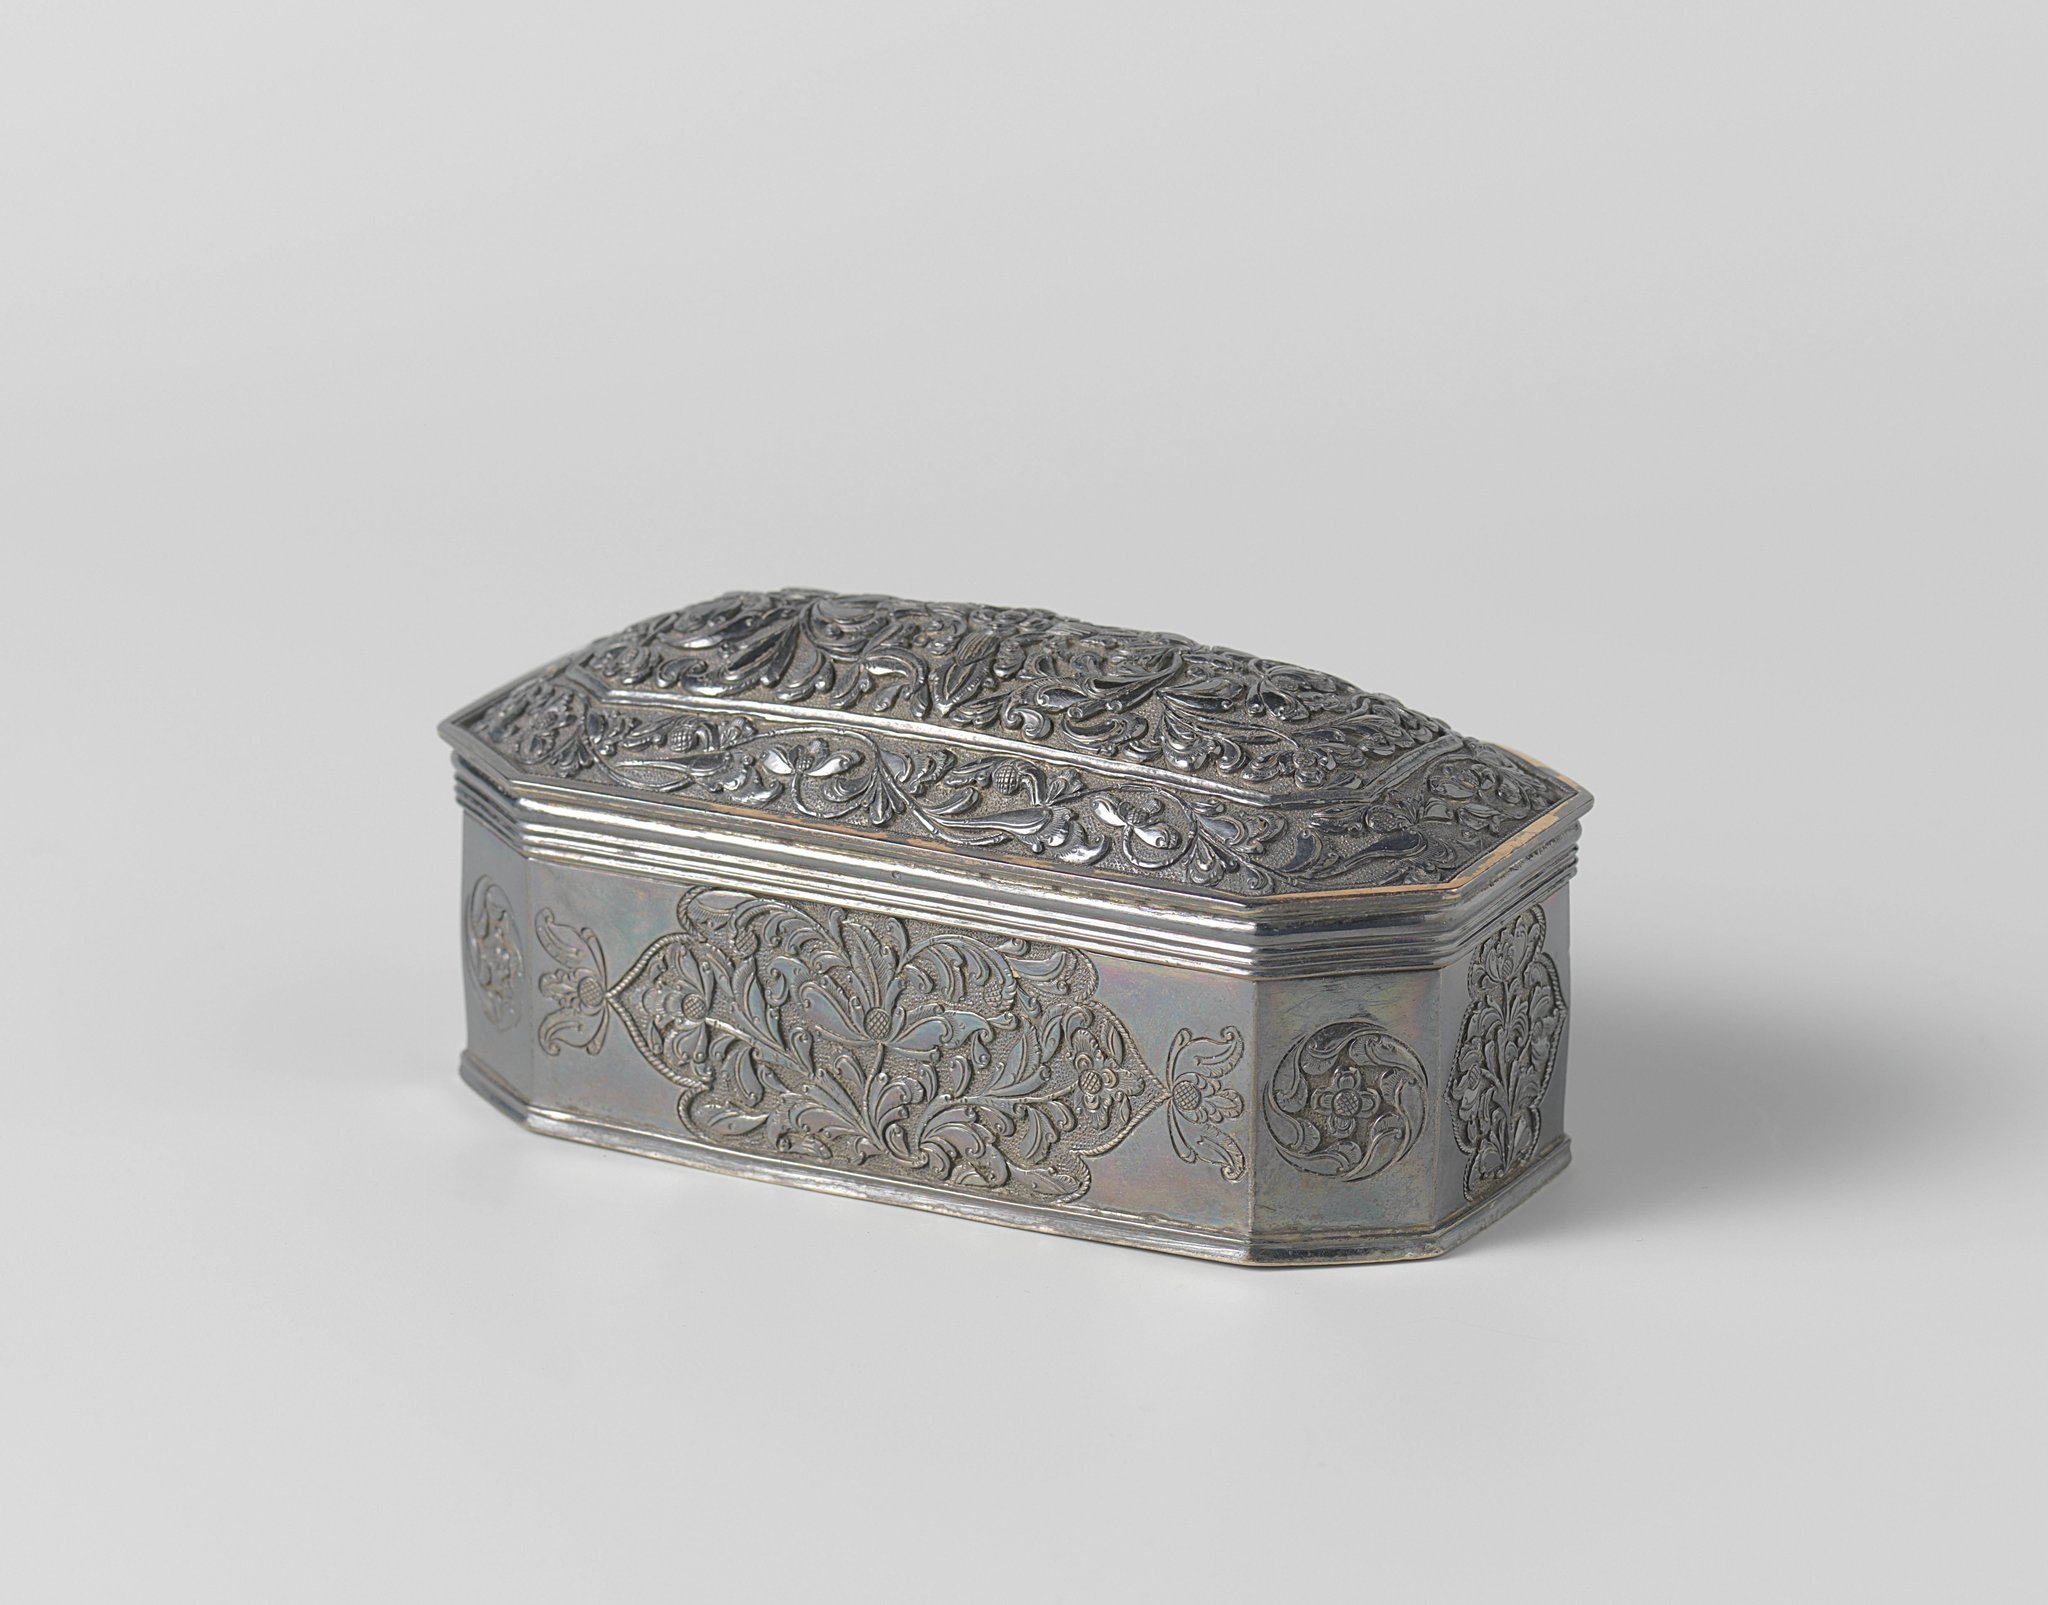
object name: tobacco box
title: Betel box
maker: Anonymous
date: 1859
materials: silver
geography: sumatra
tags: ornament derived from plant forms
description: Tabaks- of Sirihdoos versierd met bloemmotieven, gewelfde deksel, achthoekige vorm, op bodem een bloemenornament ingegrift en twee inscripties.